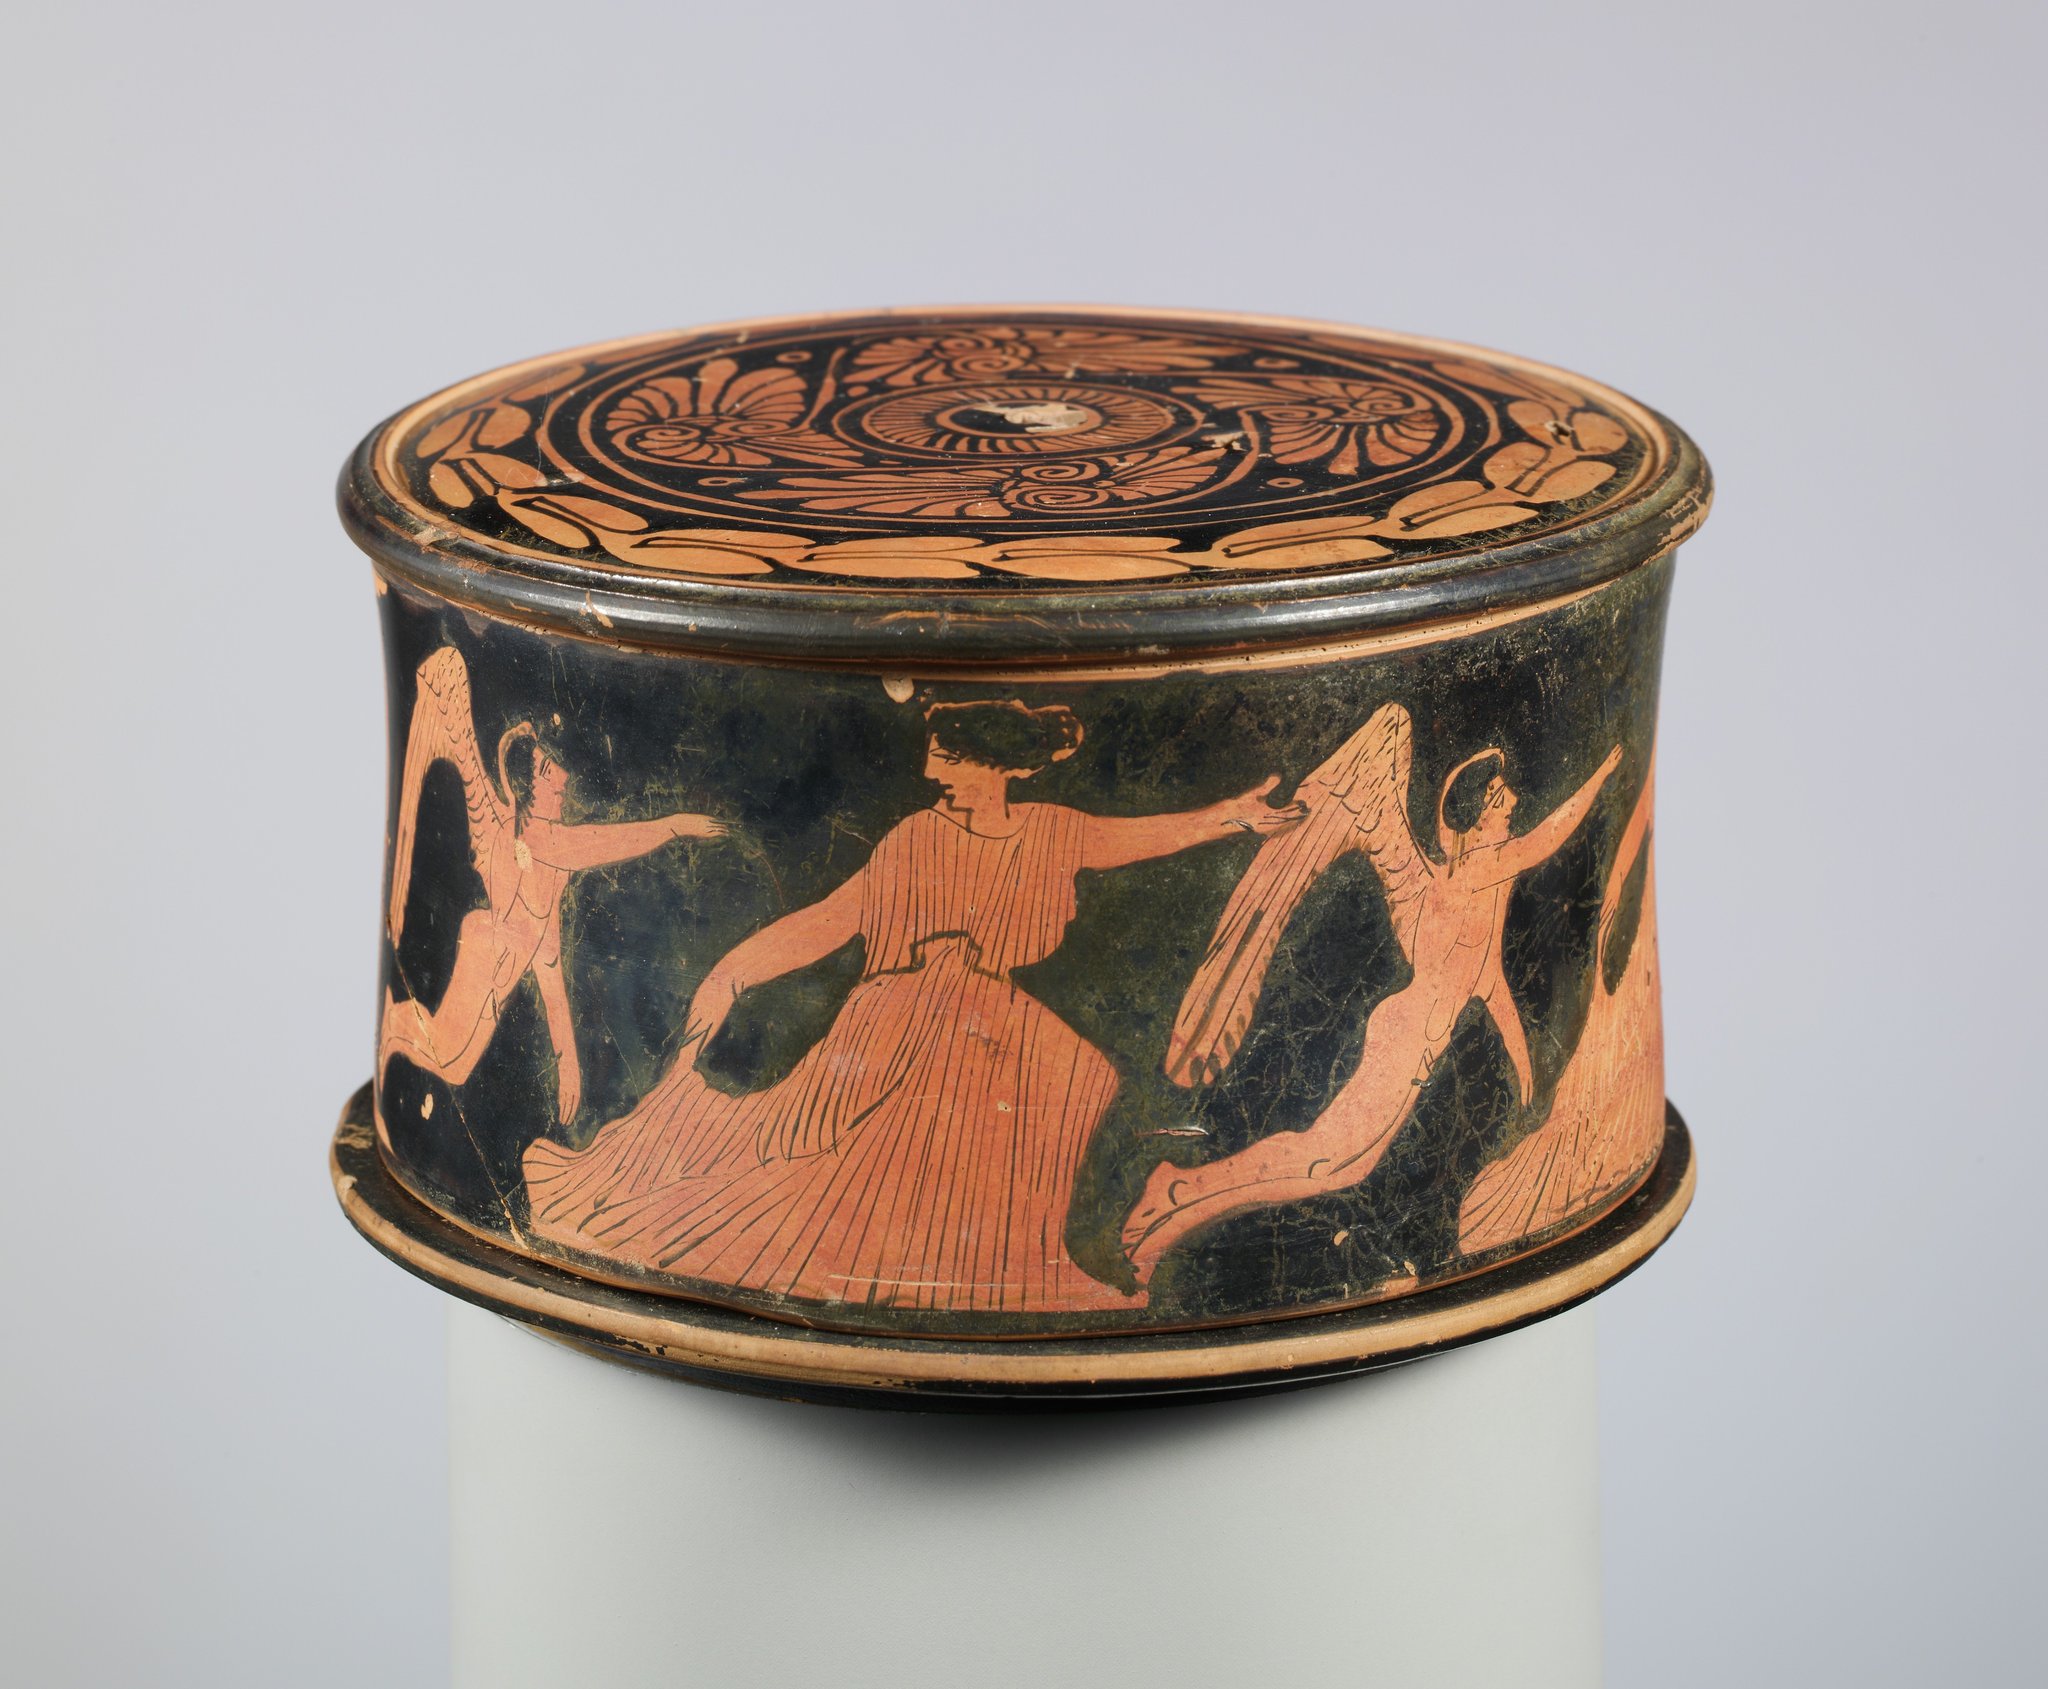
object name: pyxis with lid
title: Terracotta pyxis (box)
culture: greek, attic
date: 425-400 BCE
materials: terracotta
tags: women,eros